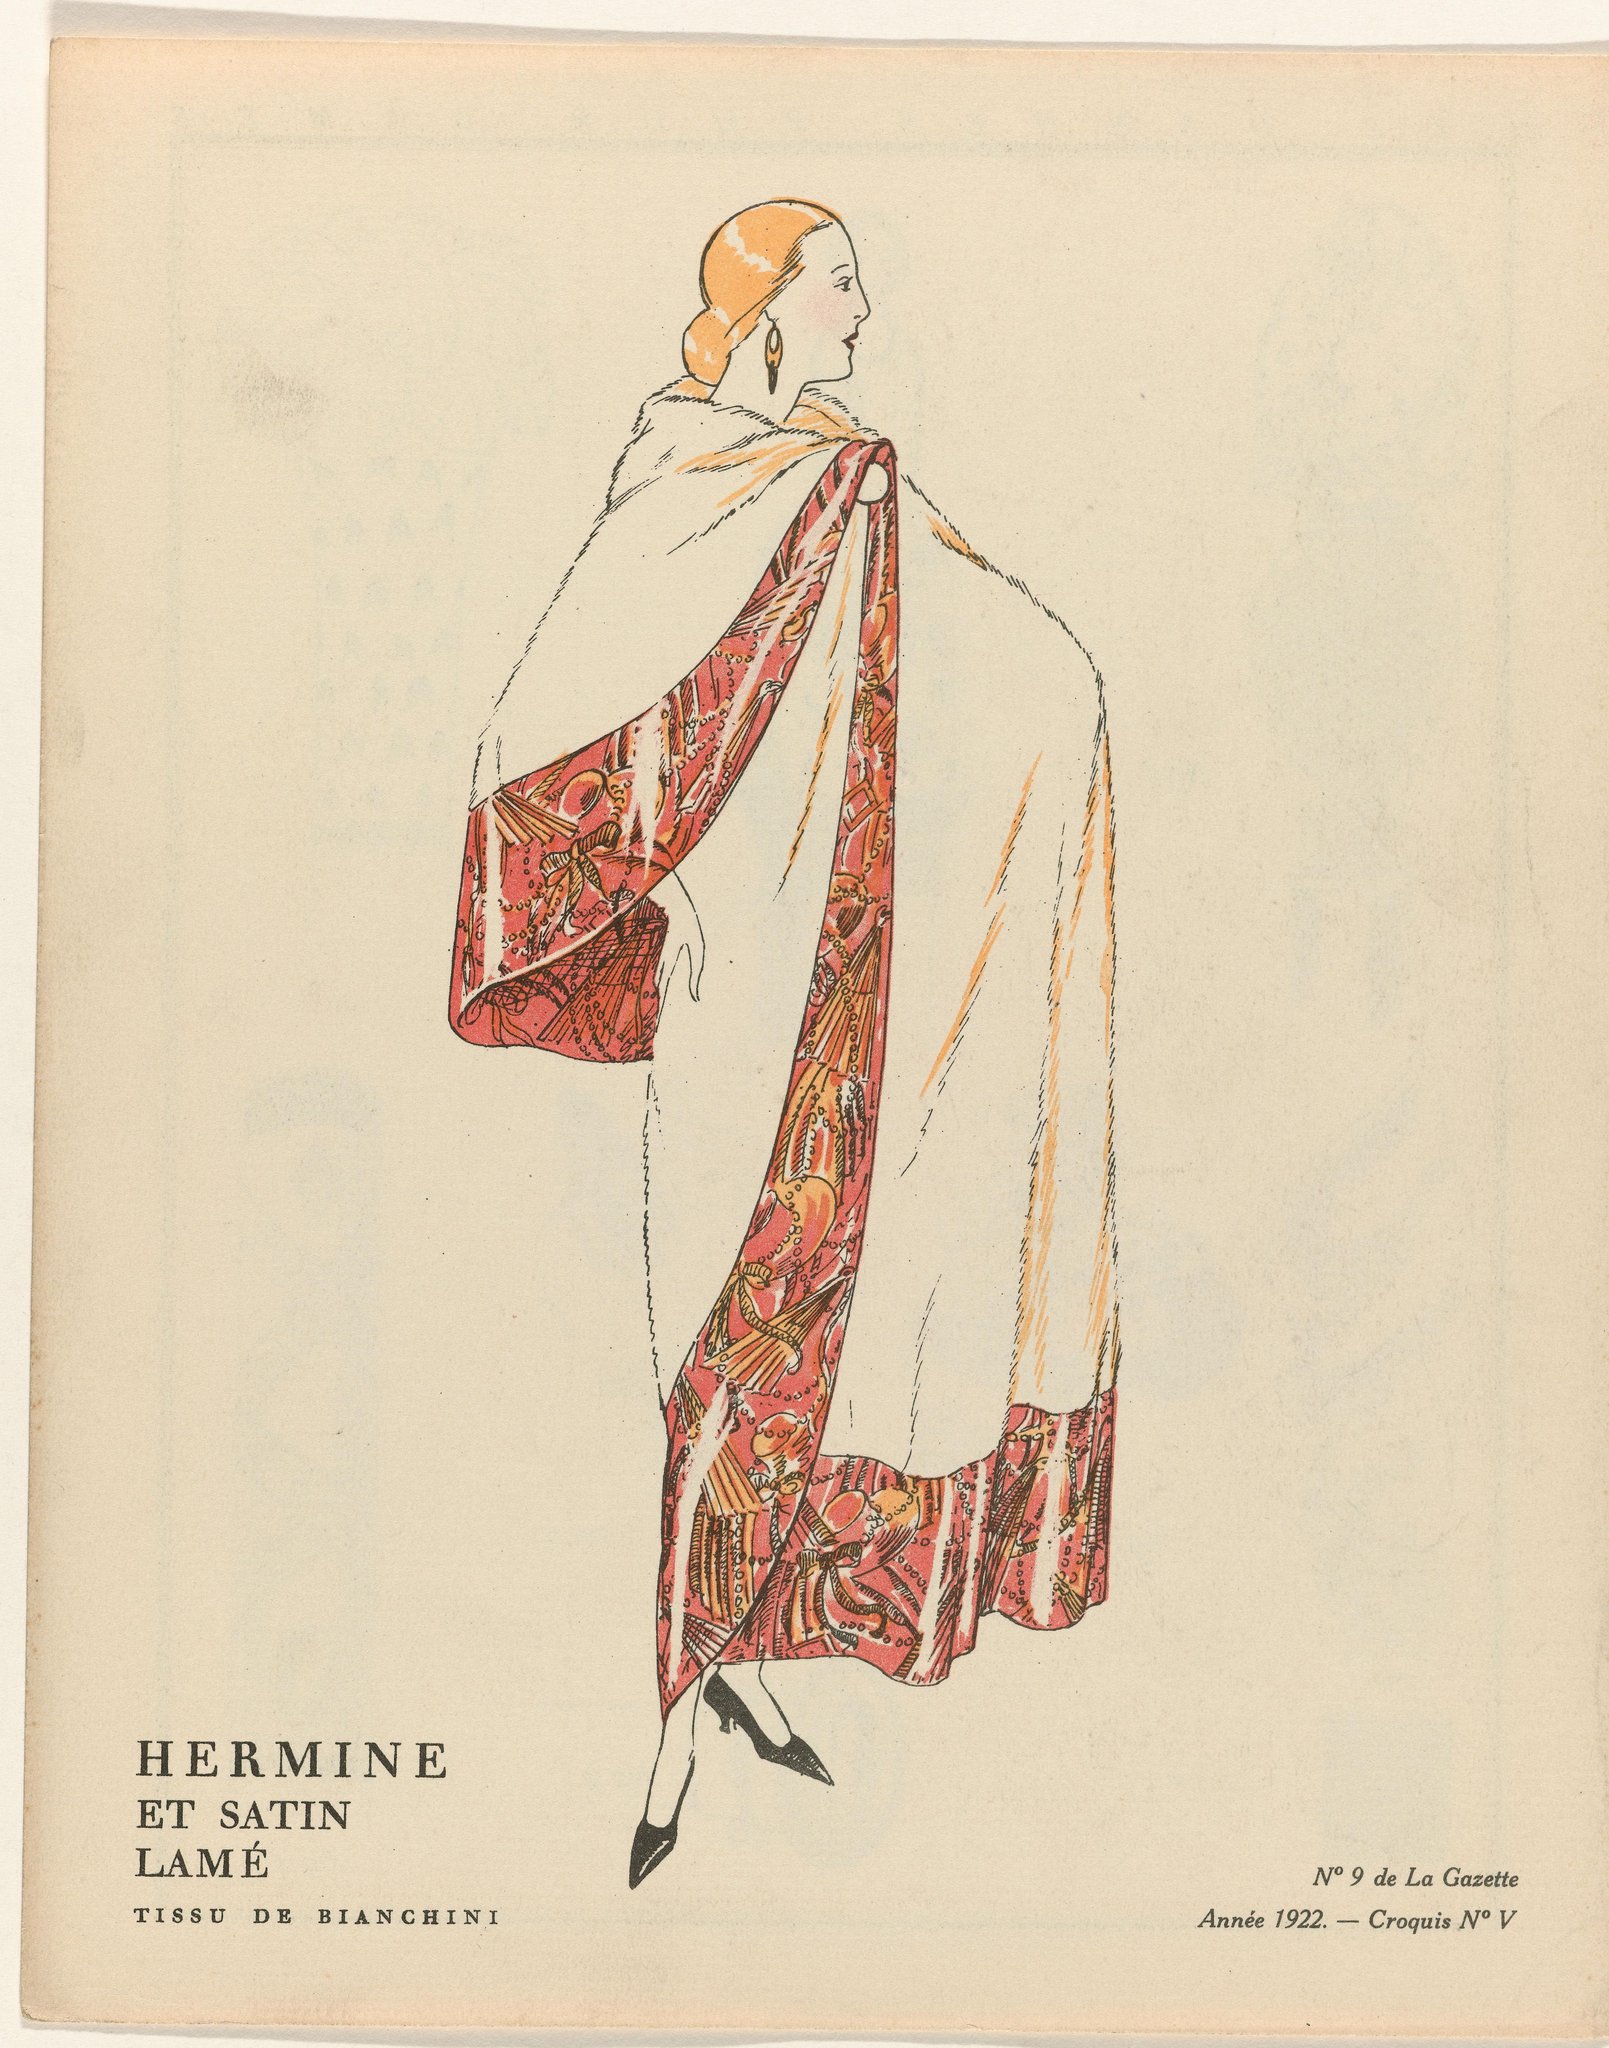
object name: fashion print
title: Gazette du Bon Ton, 1922 - No. 9 : Hermine et satin lamé / Tissu de Bianchini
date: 1922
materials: paper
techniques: printing, letterpress printing, photochemical processes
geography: new york city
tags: ear-rings (+ women's clothes), coat (+ women's clothes), fashion plates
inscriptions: date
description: Avondcape van hermelijn, afgezet met een brede band met een dessin van waaiers en hoeden, van Bianchini. Croquis No V uit Gazette du Bon Ton 1922, No. 9. Uitleg over de kleding op pagina "Recto des pages de croquis. Contenues dans ce fascicule (Modèles de la gazette)."